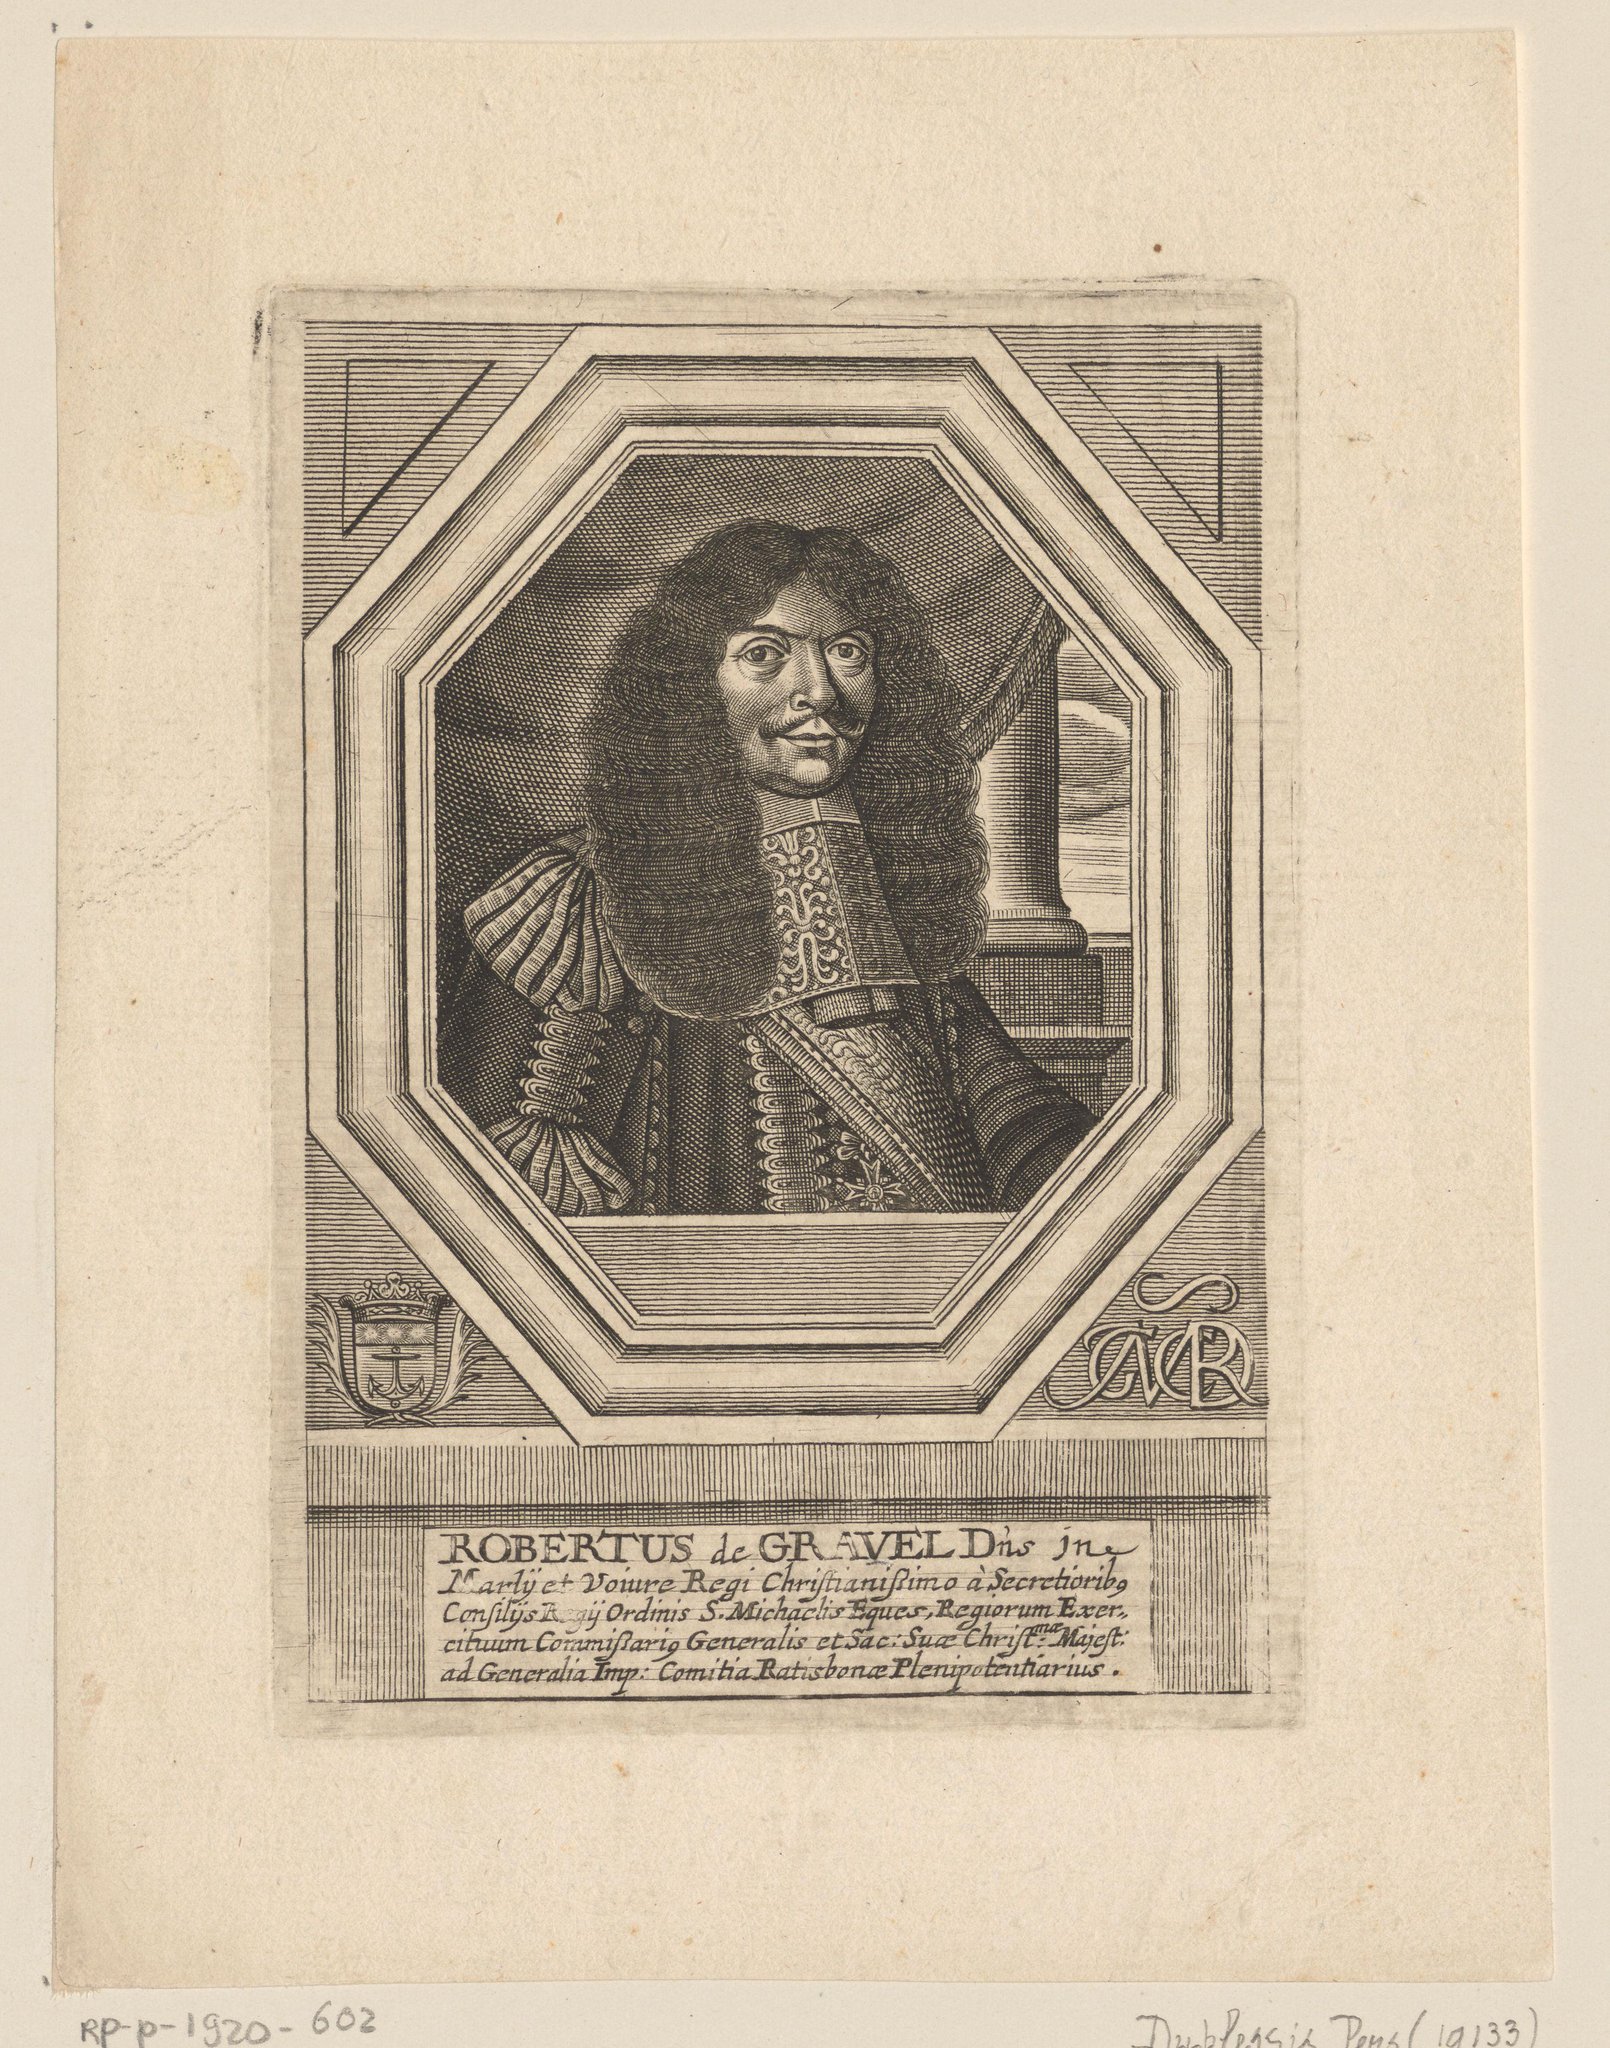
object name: print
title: Portret van Robert de Gravel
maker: matthias van sommer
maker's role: draughtsman, print maker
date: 1643-1672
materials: paper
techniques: engraving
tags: historical persons, diplomacy, diplomat